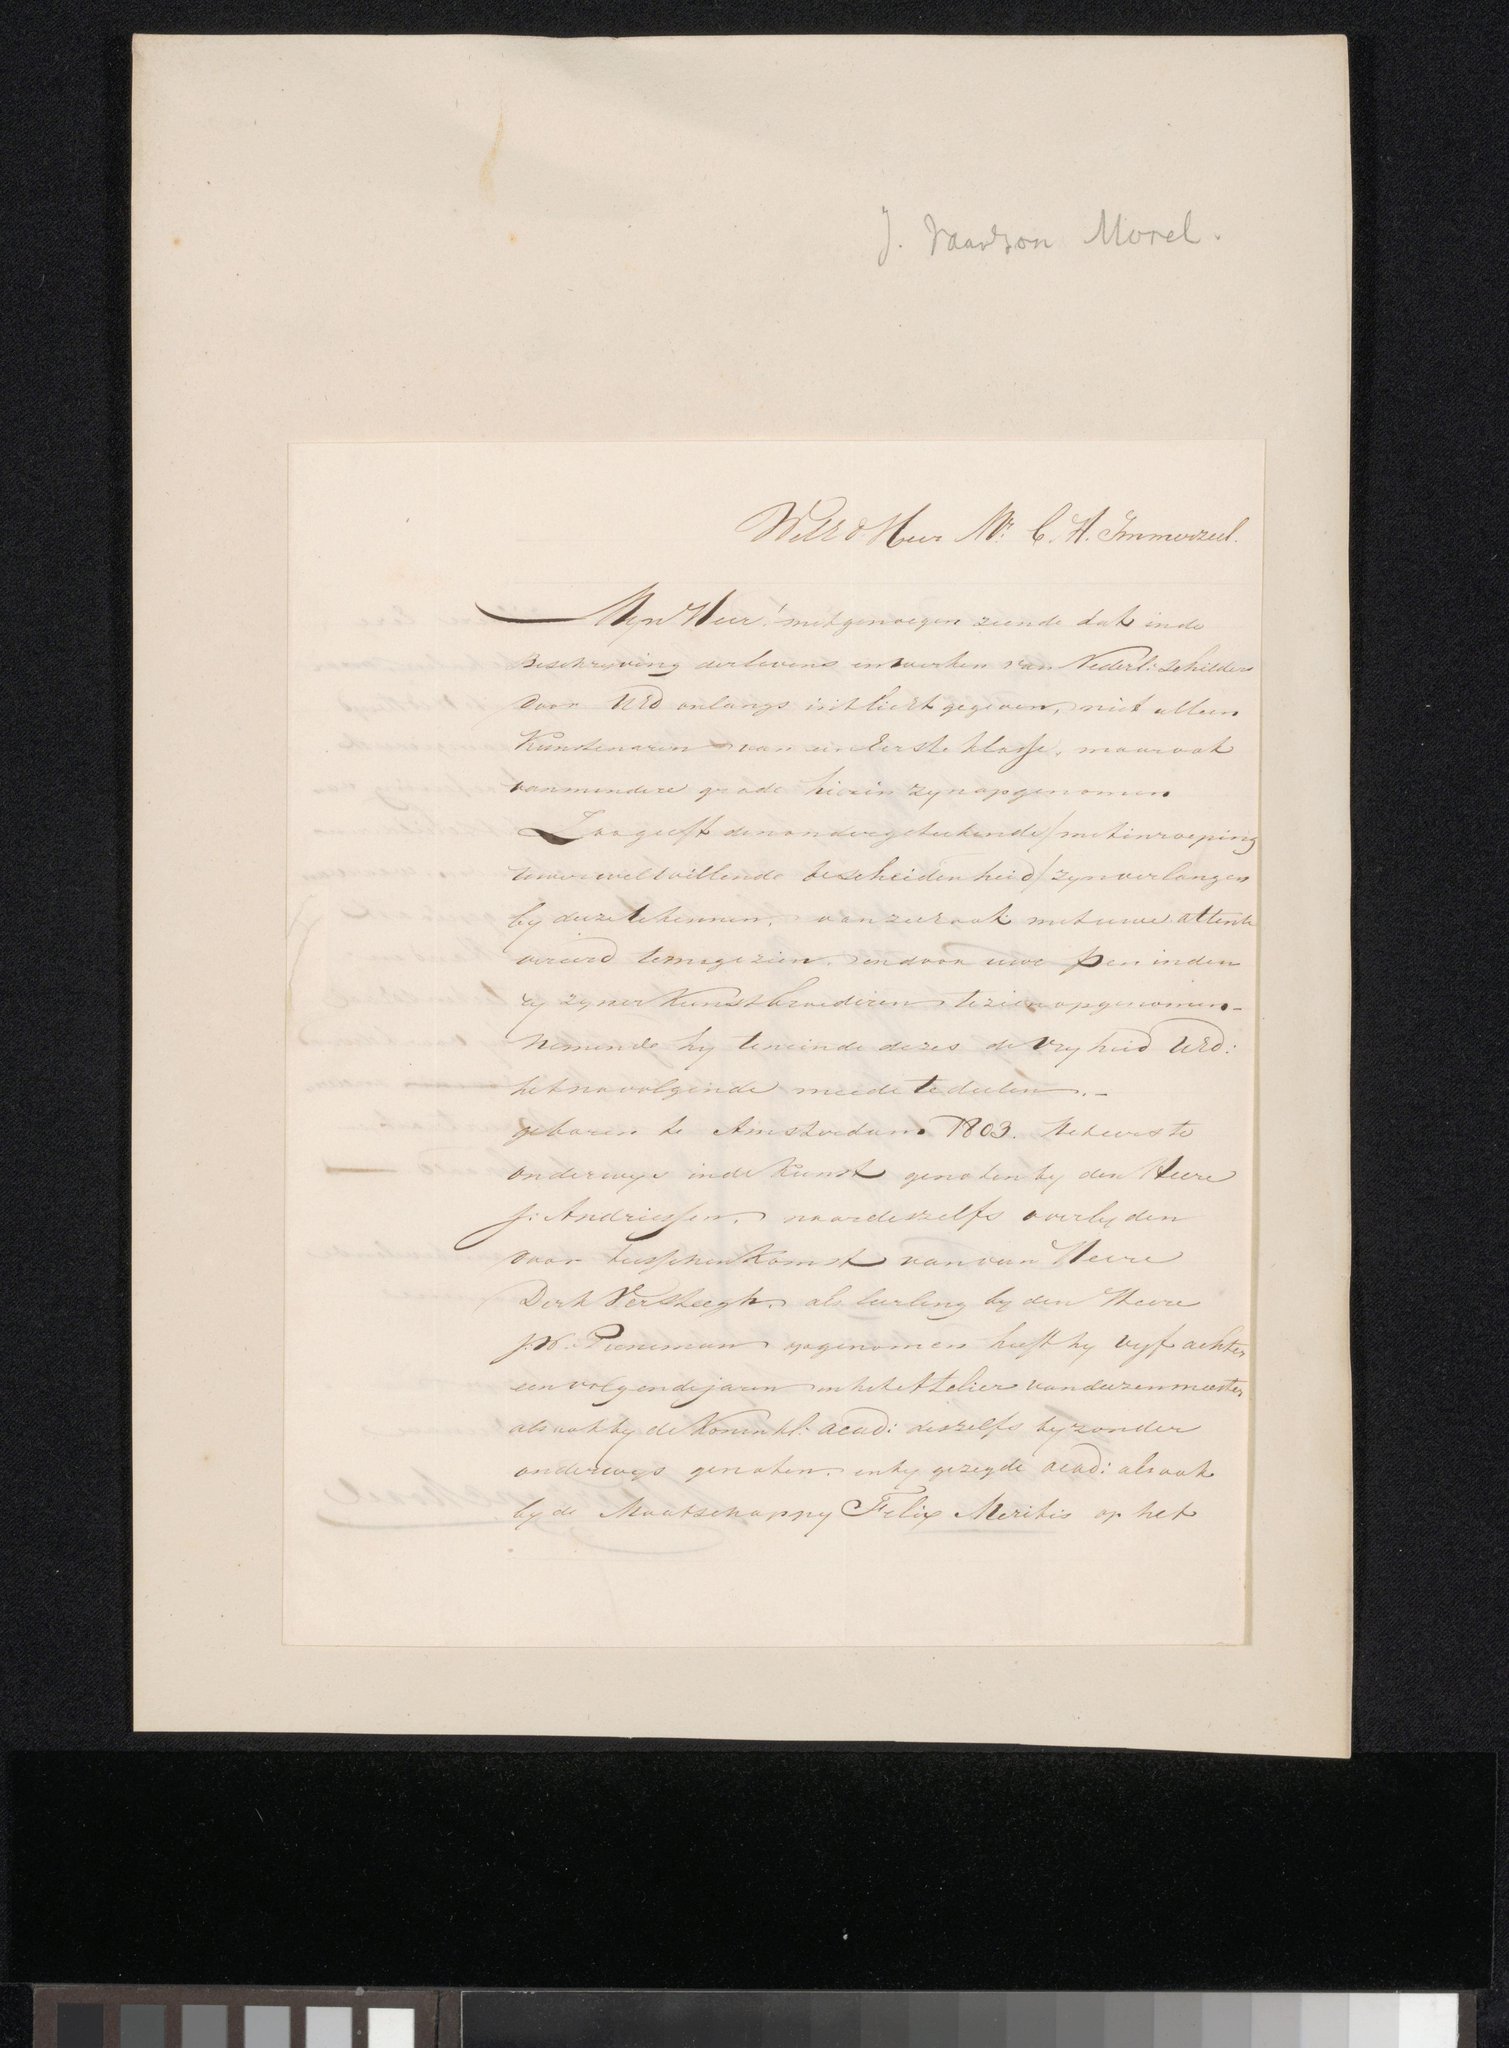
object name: letter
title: Brief aan Christiaan Immerzeel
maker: izaak vaarzon morel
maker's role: draughtsman, painter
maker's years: 1803-1876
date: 1842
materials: ink, paper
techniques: pen, writing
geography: gorinchem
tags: abcoude, amsterdam, painter, jan willem pieneman, jurriaan andriessen, the hague, print maker, christiaan immerzeel, drawing, education, tuition of the artist (in general), painting (including book-illumination, miniature-painting), workshop, studio of the artist (in general)